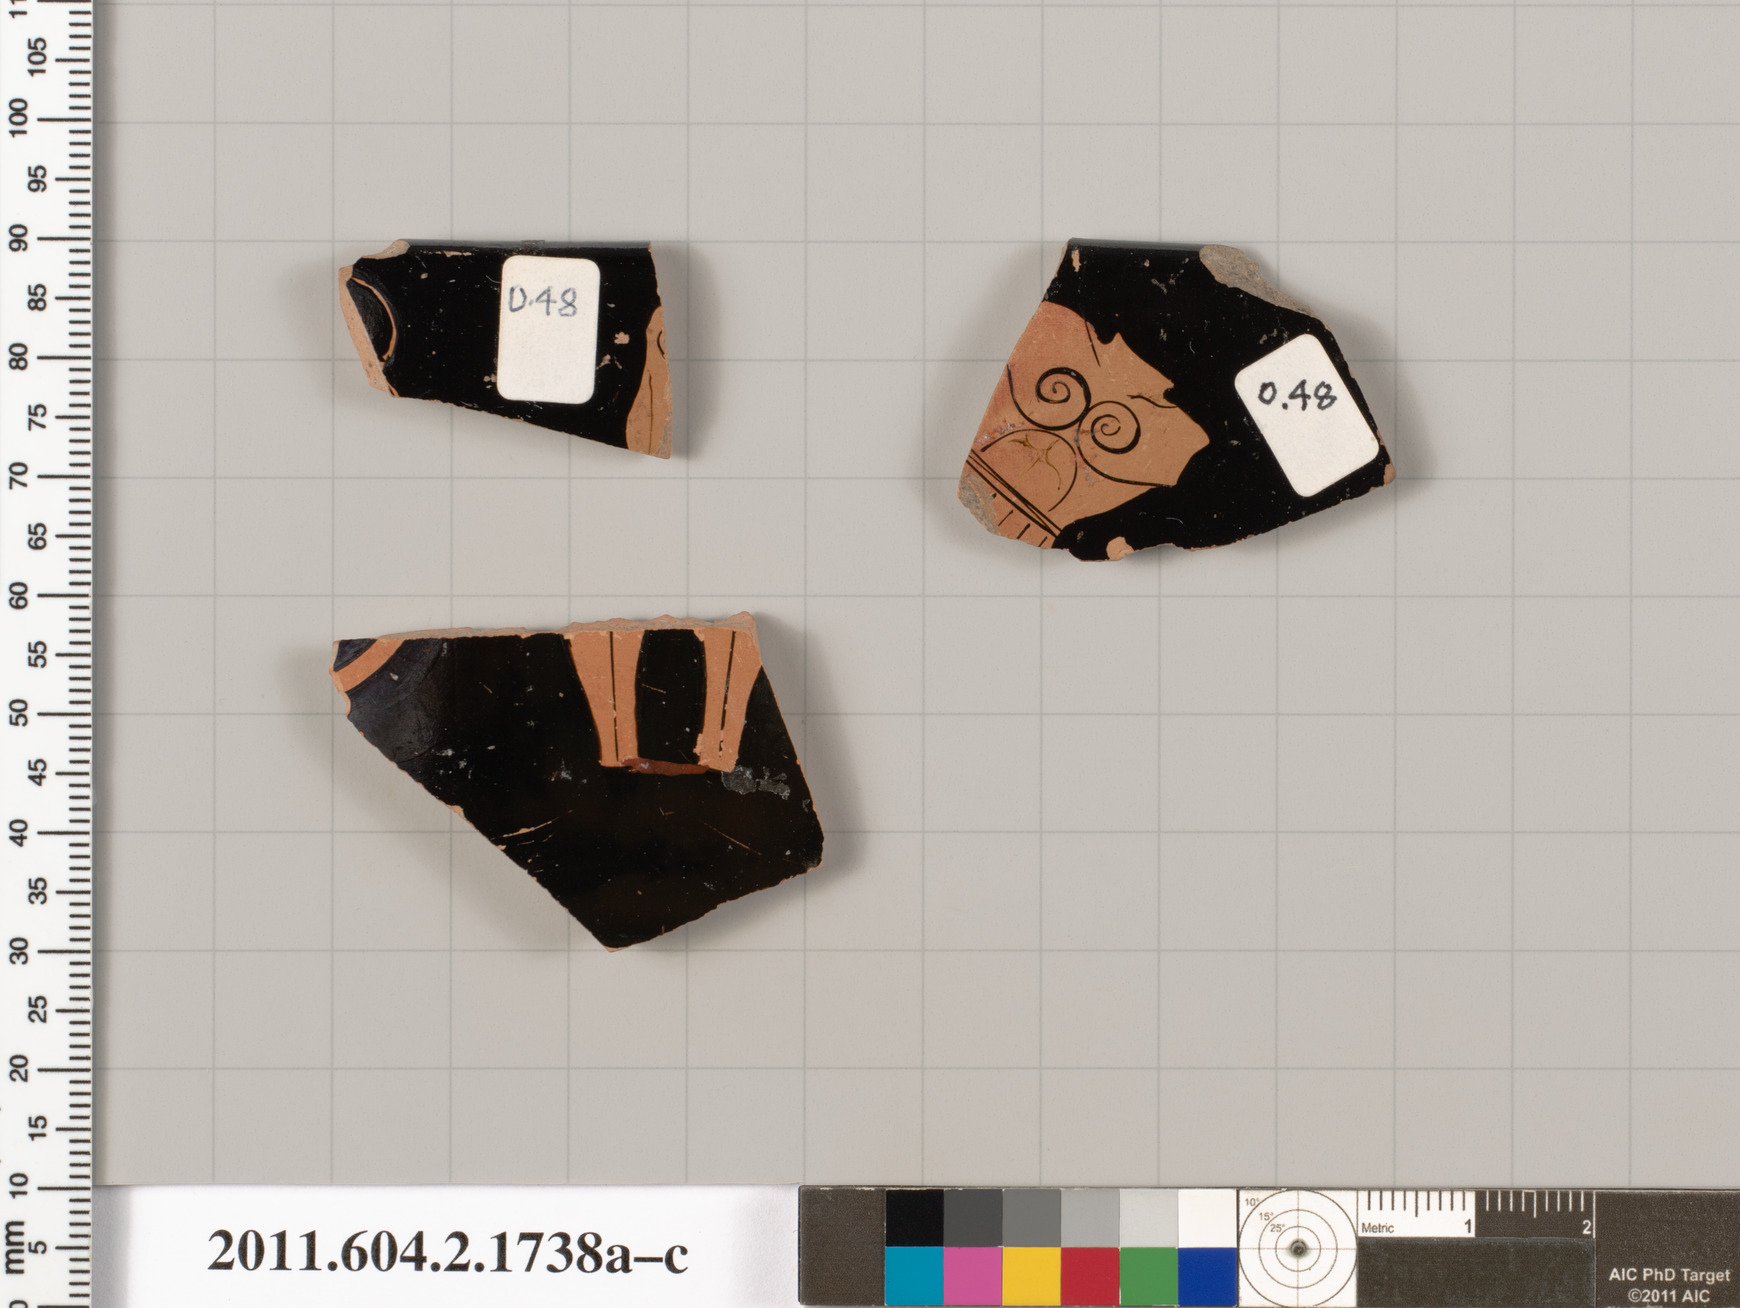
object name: skyphos fragment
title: Terracotta fragments of a skyphos (deep drinking cup)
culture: greek, attic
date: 490-470 BCE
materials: terracotta